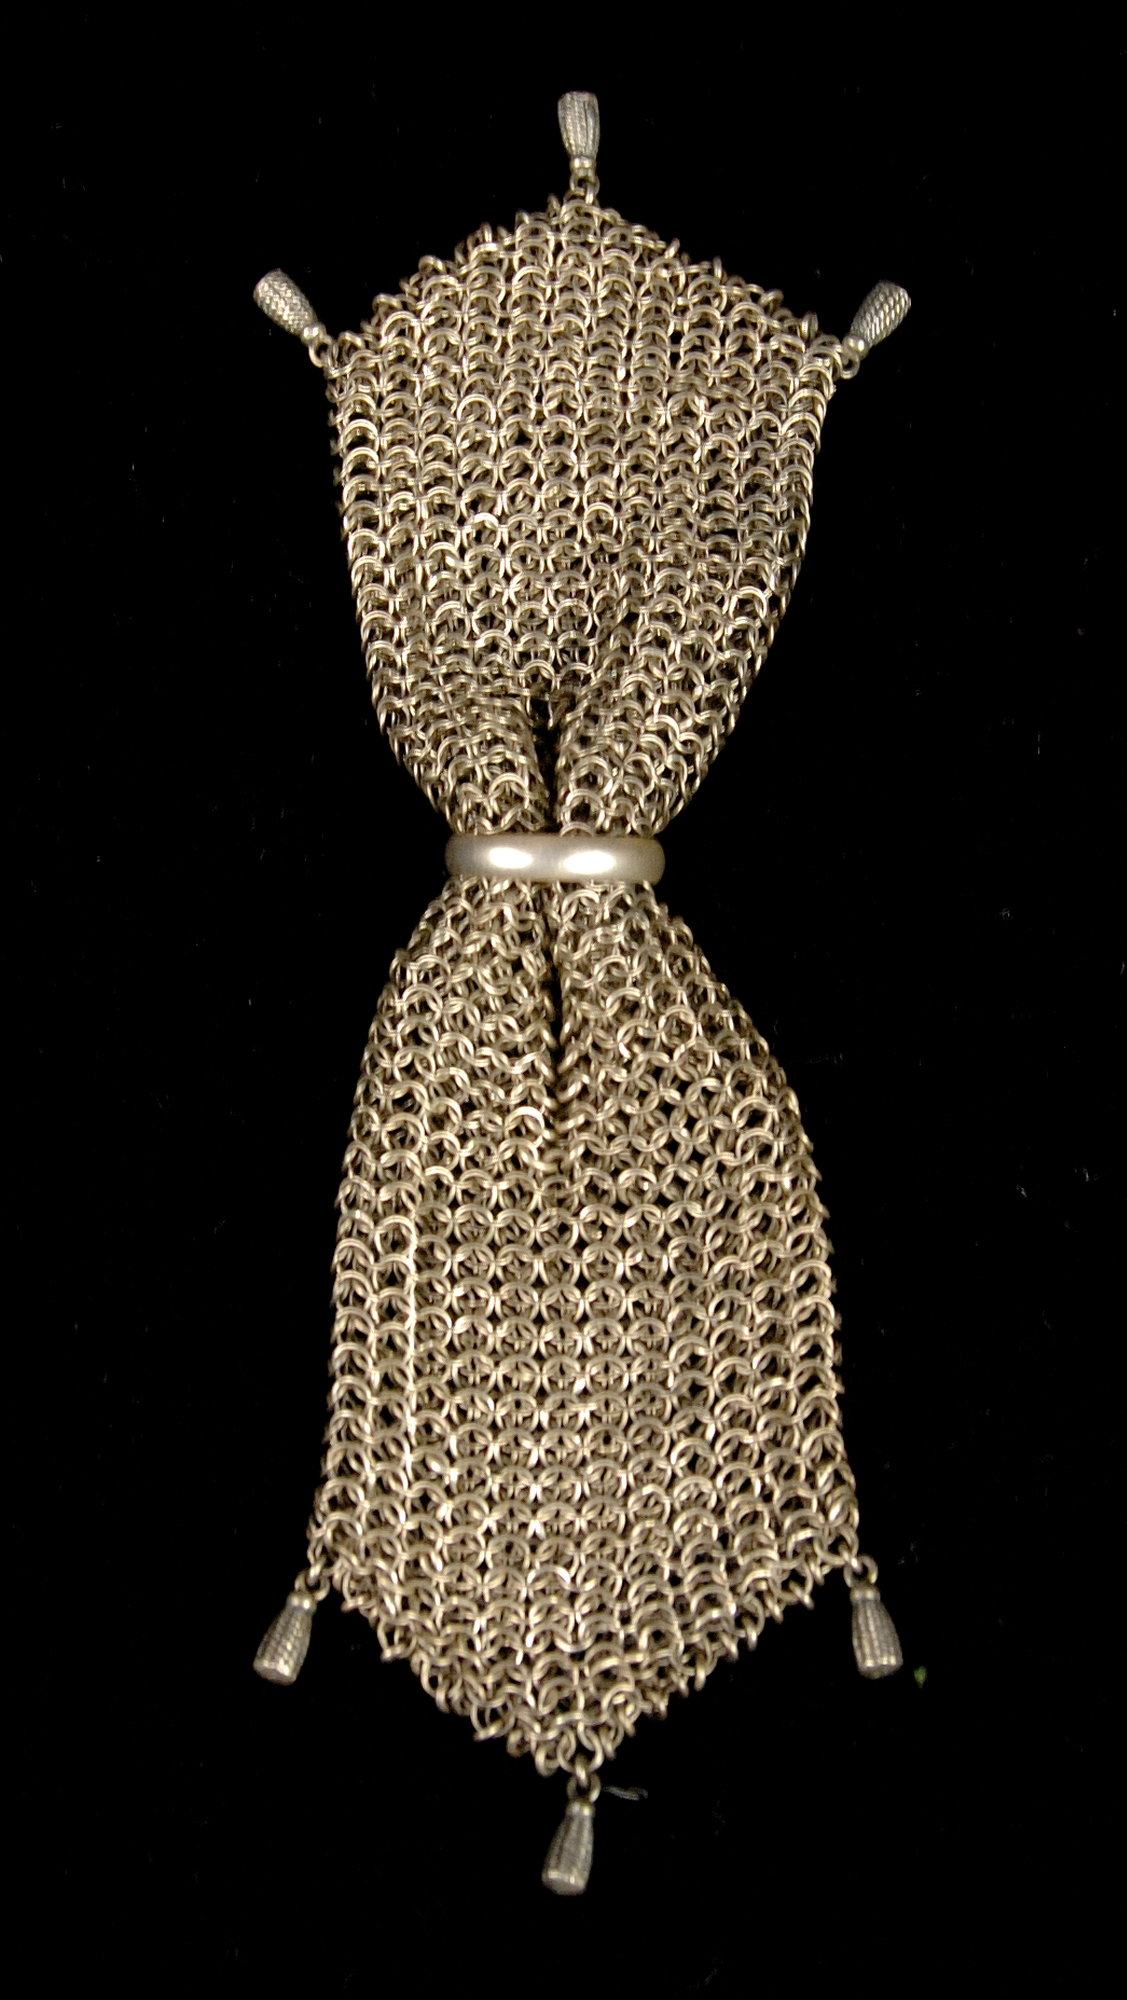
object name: miser's purse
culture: american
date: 1851-1875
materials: metal